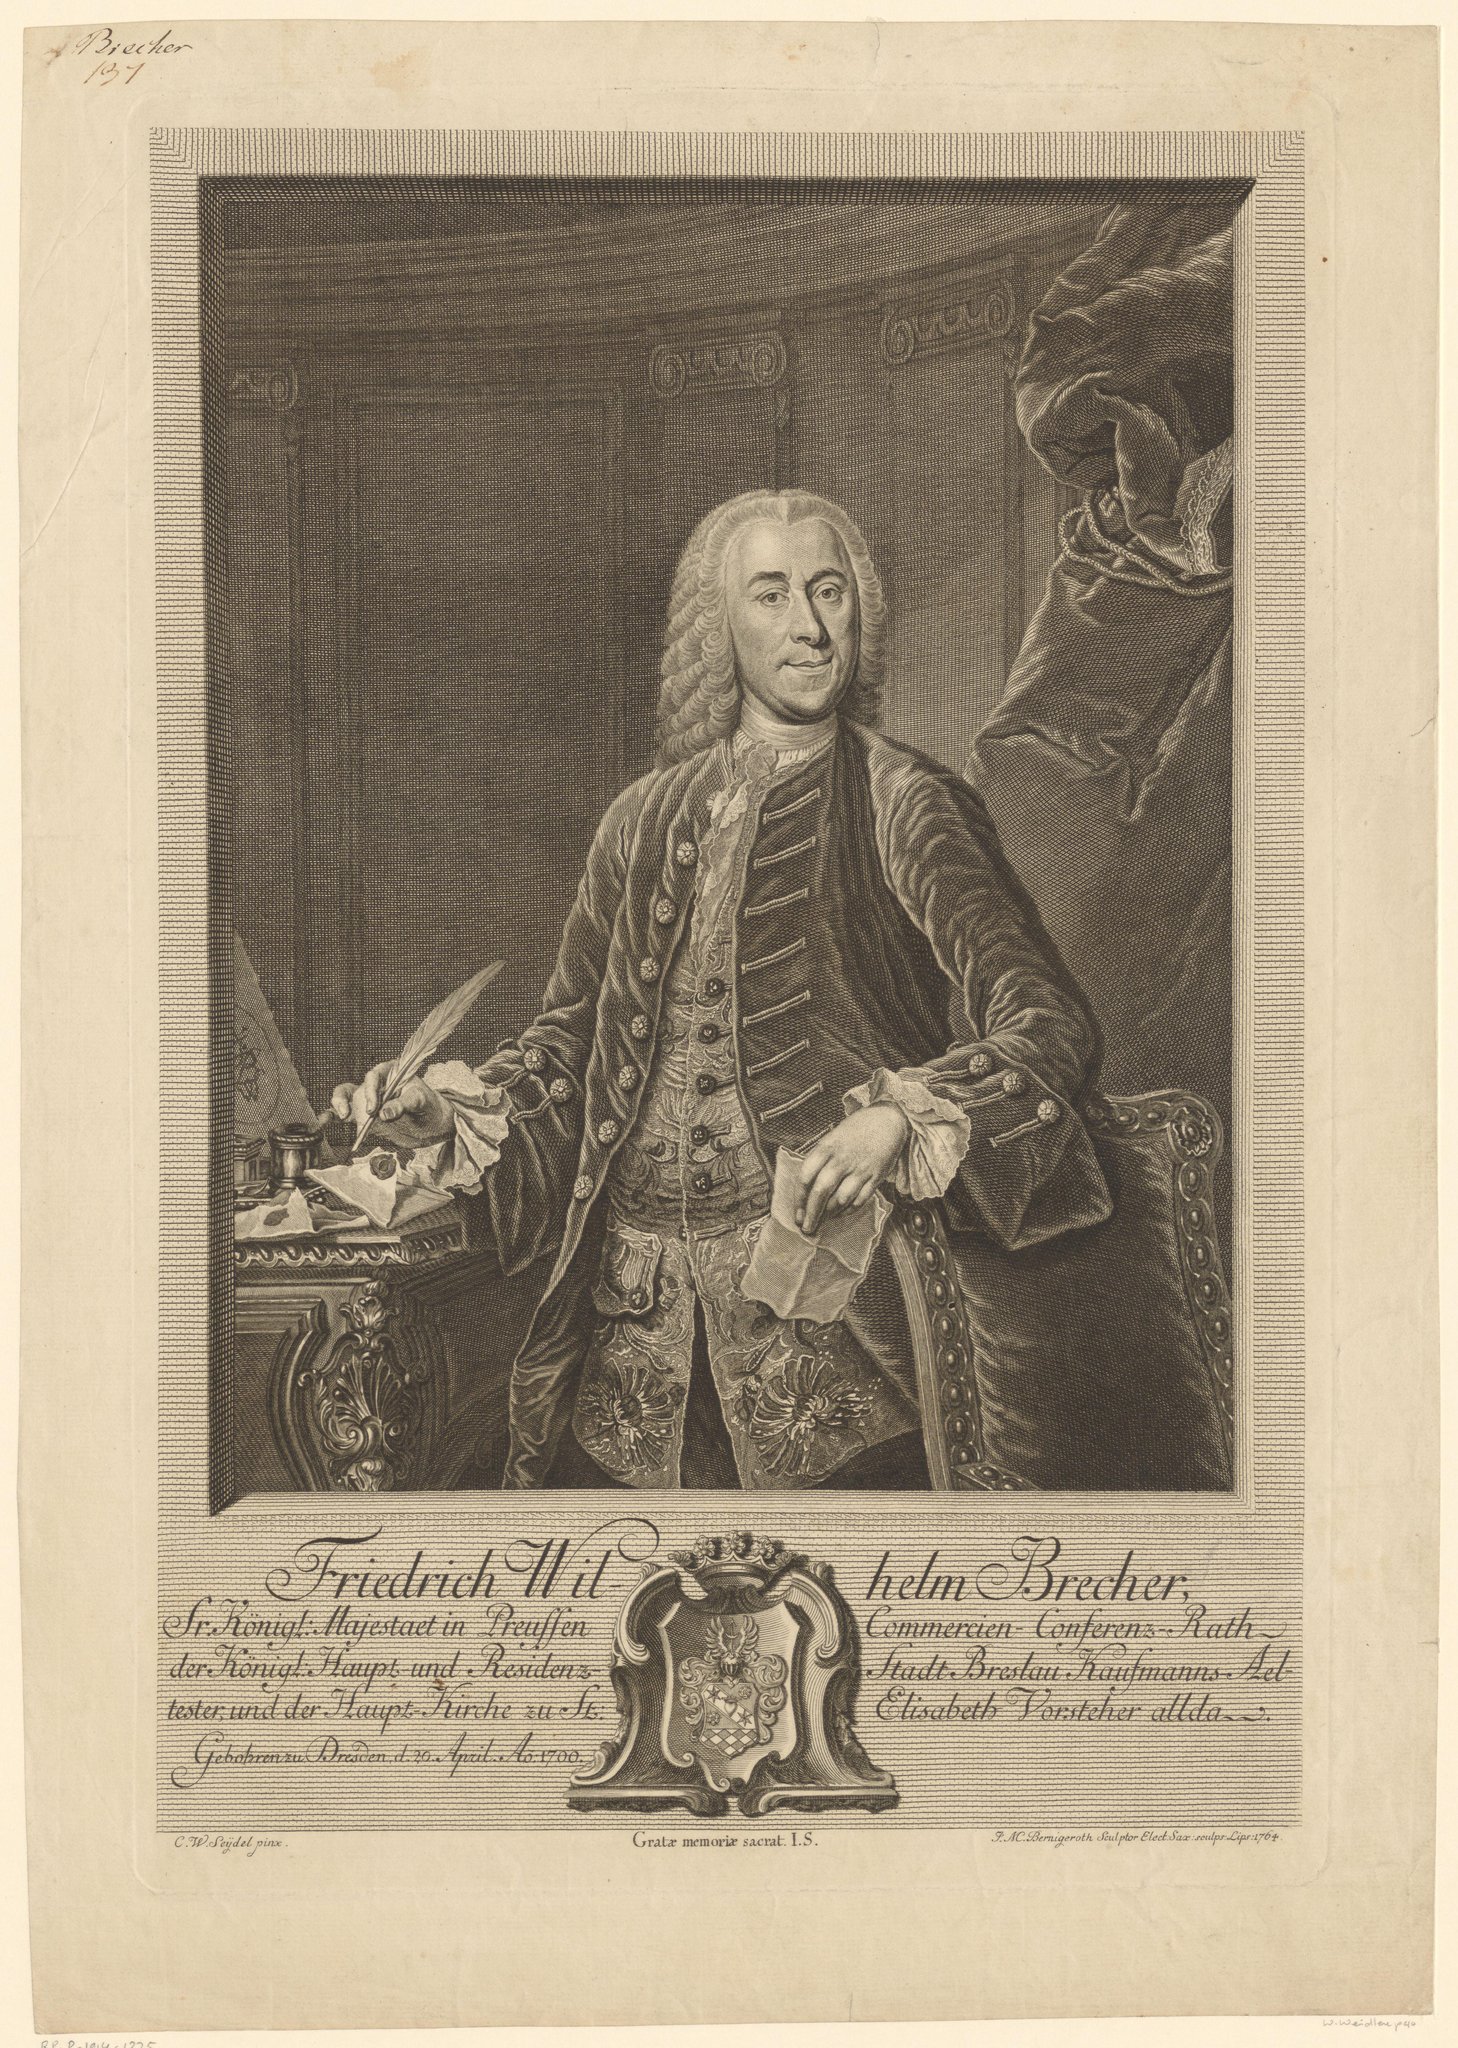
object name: print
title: Portret van Friedrich Wilhelm Brecher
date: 1764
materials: paper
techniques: engraving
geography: leipzig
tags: quill, ink-well, historical persons, letter, envelope, armorial bearing, heraldry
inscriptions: collector's mark: Lugt 2228